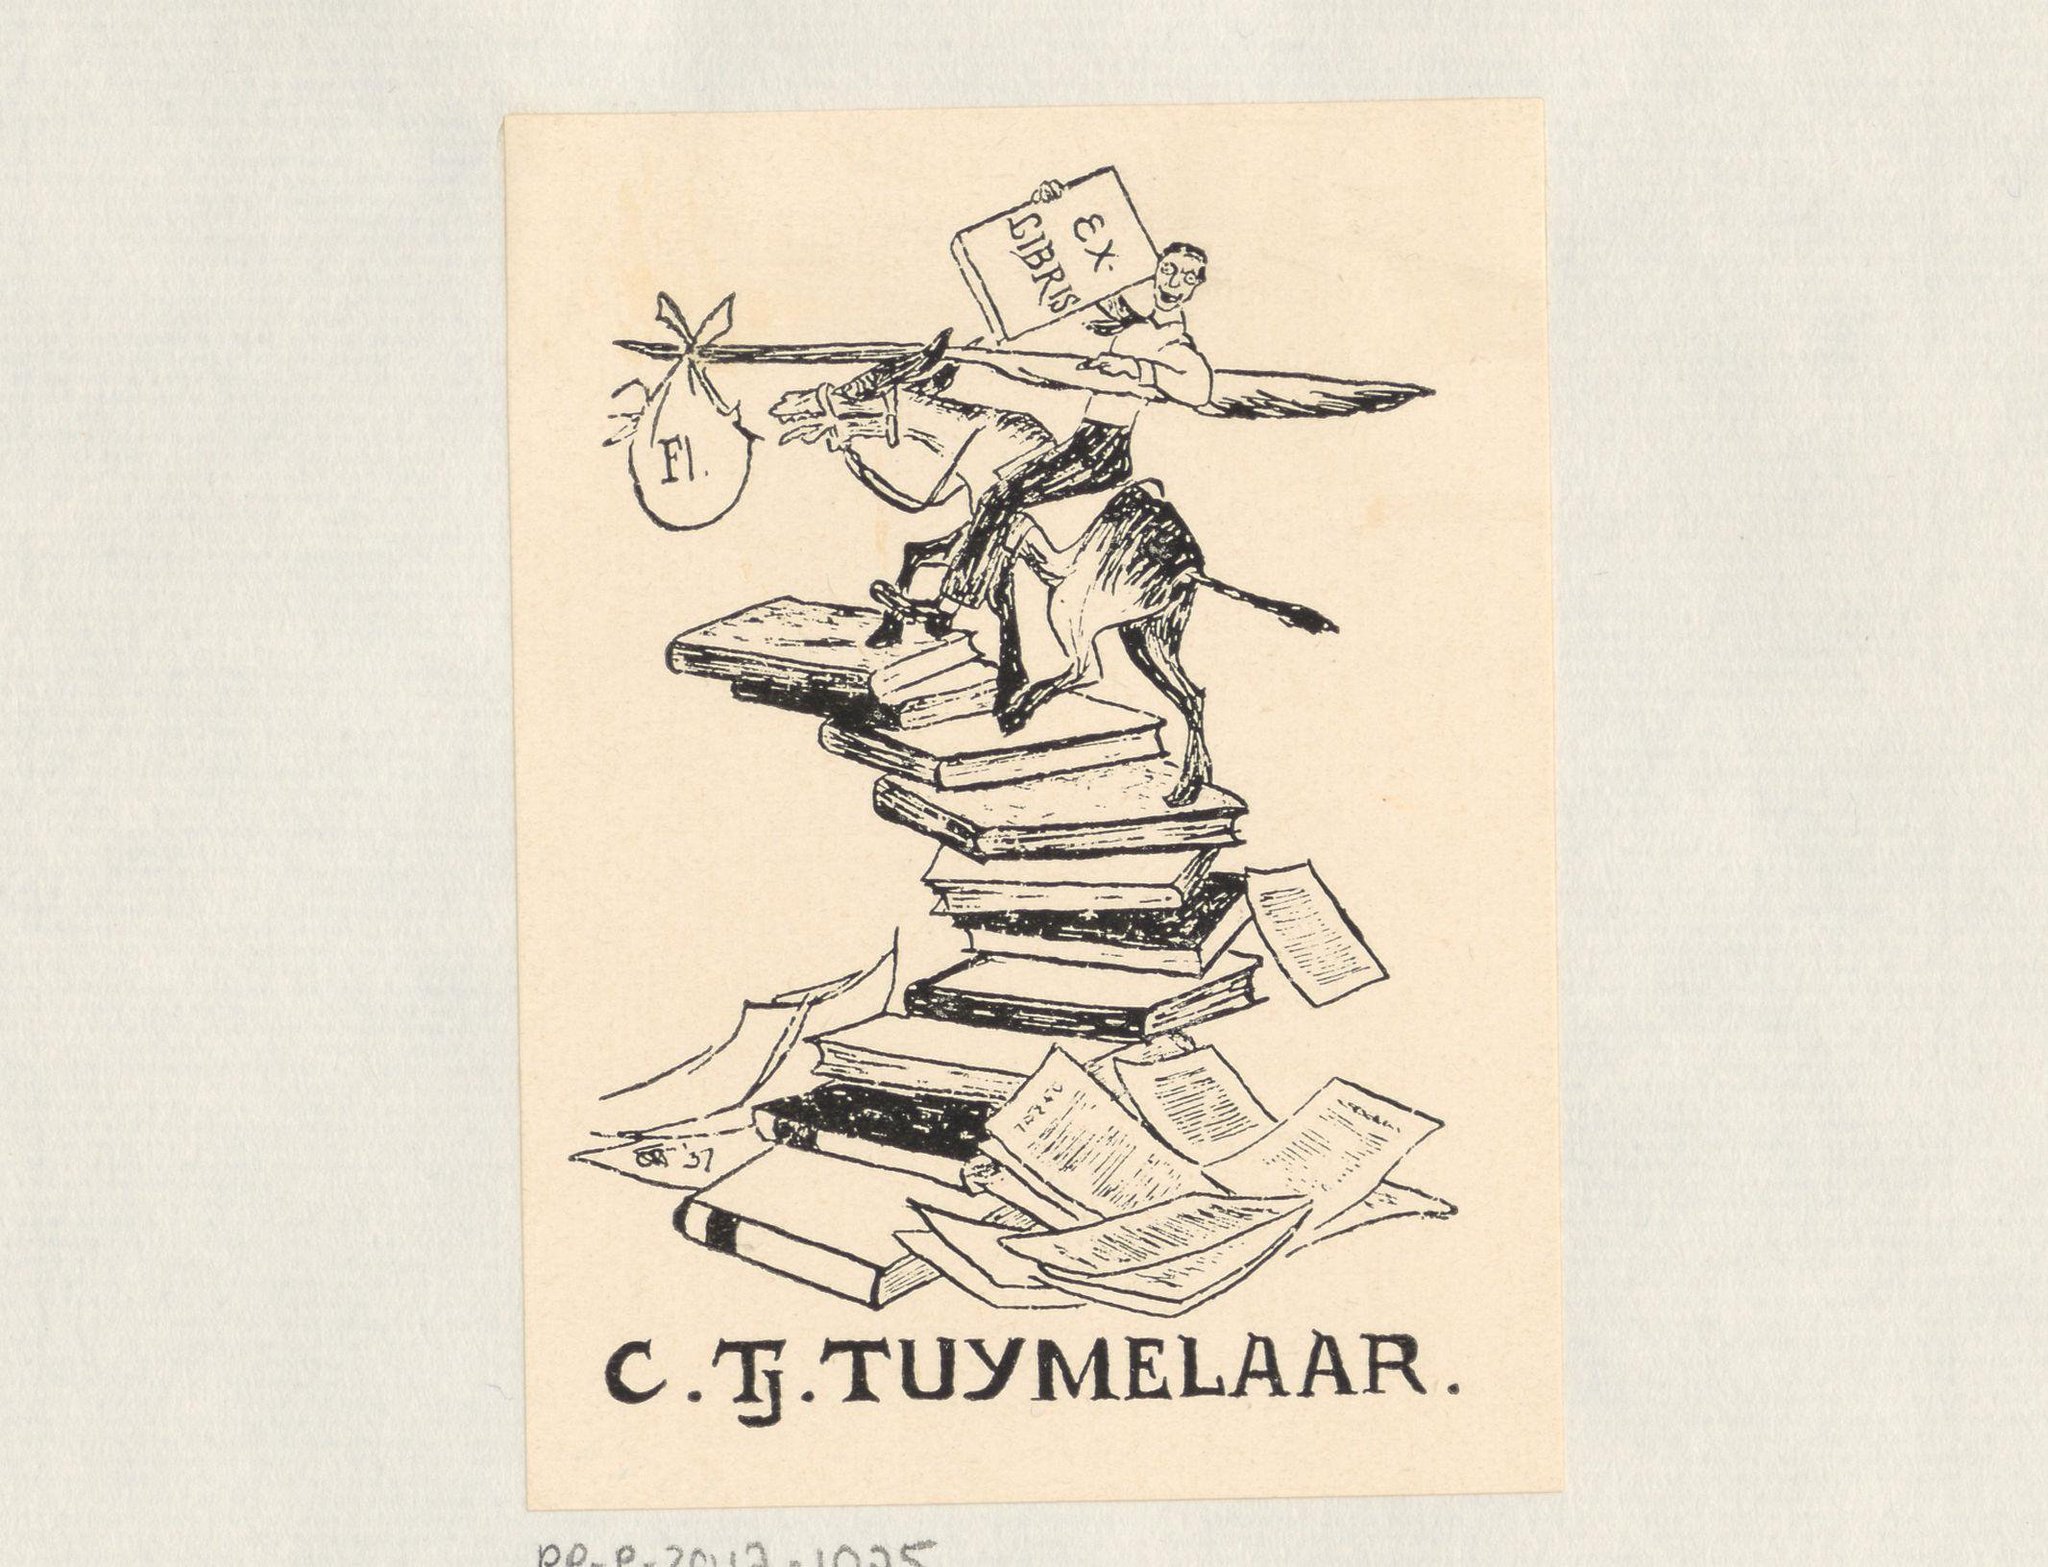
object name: bookplate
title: Ex libris van C.Tj. Tuymelaar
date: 1937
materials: paper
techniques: printing block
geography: netherlands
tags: c.tj. tuymelaar, riding a horse, ass, or mule; rider, horseman, quill, ass, donkey, book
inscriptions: signature, date and inscription: ‘CTj Tuymelaar / Cl. '37’